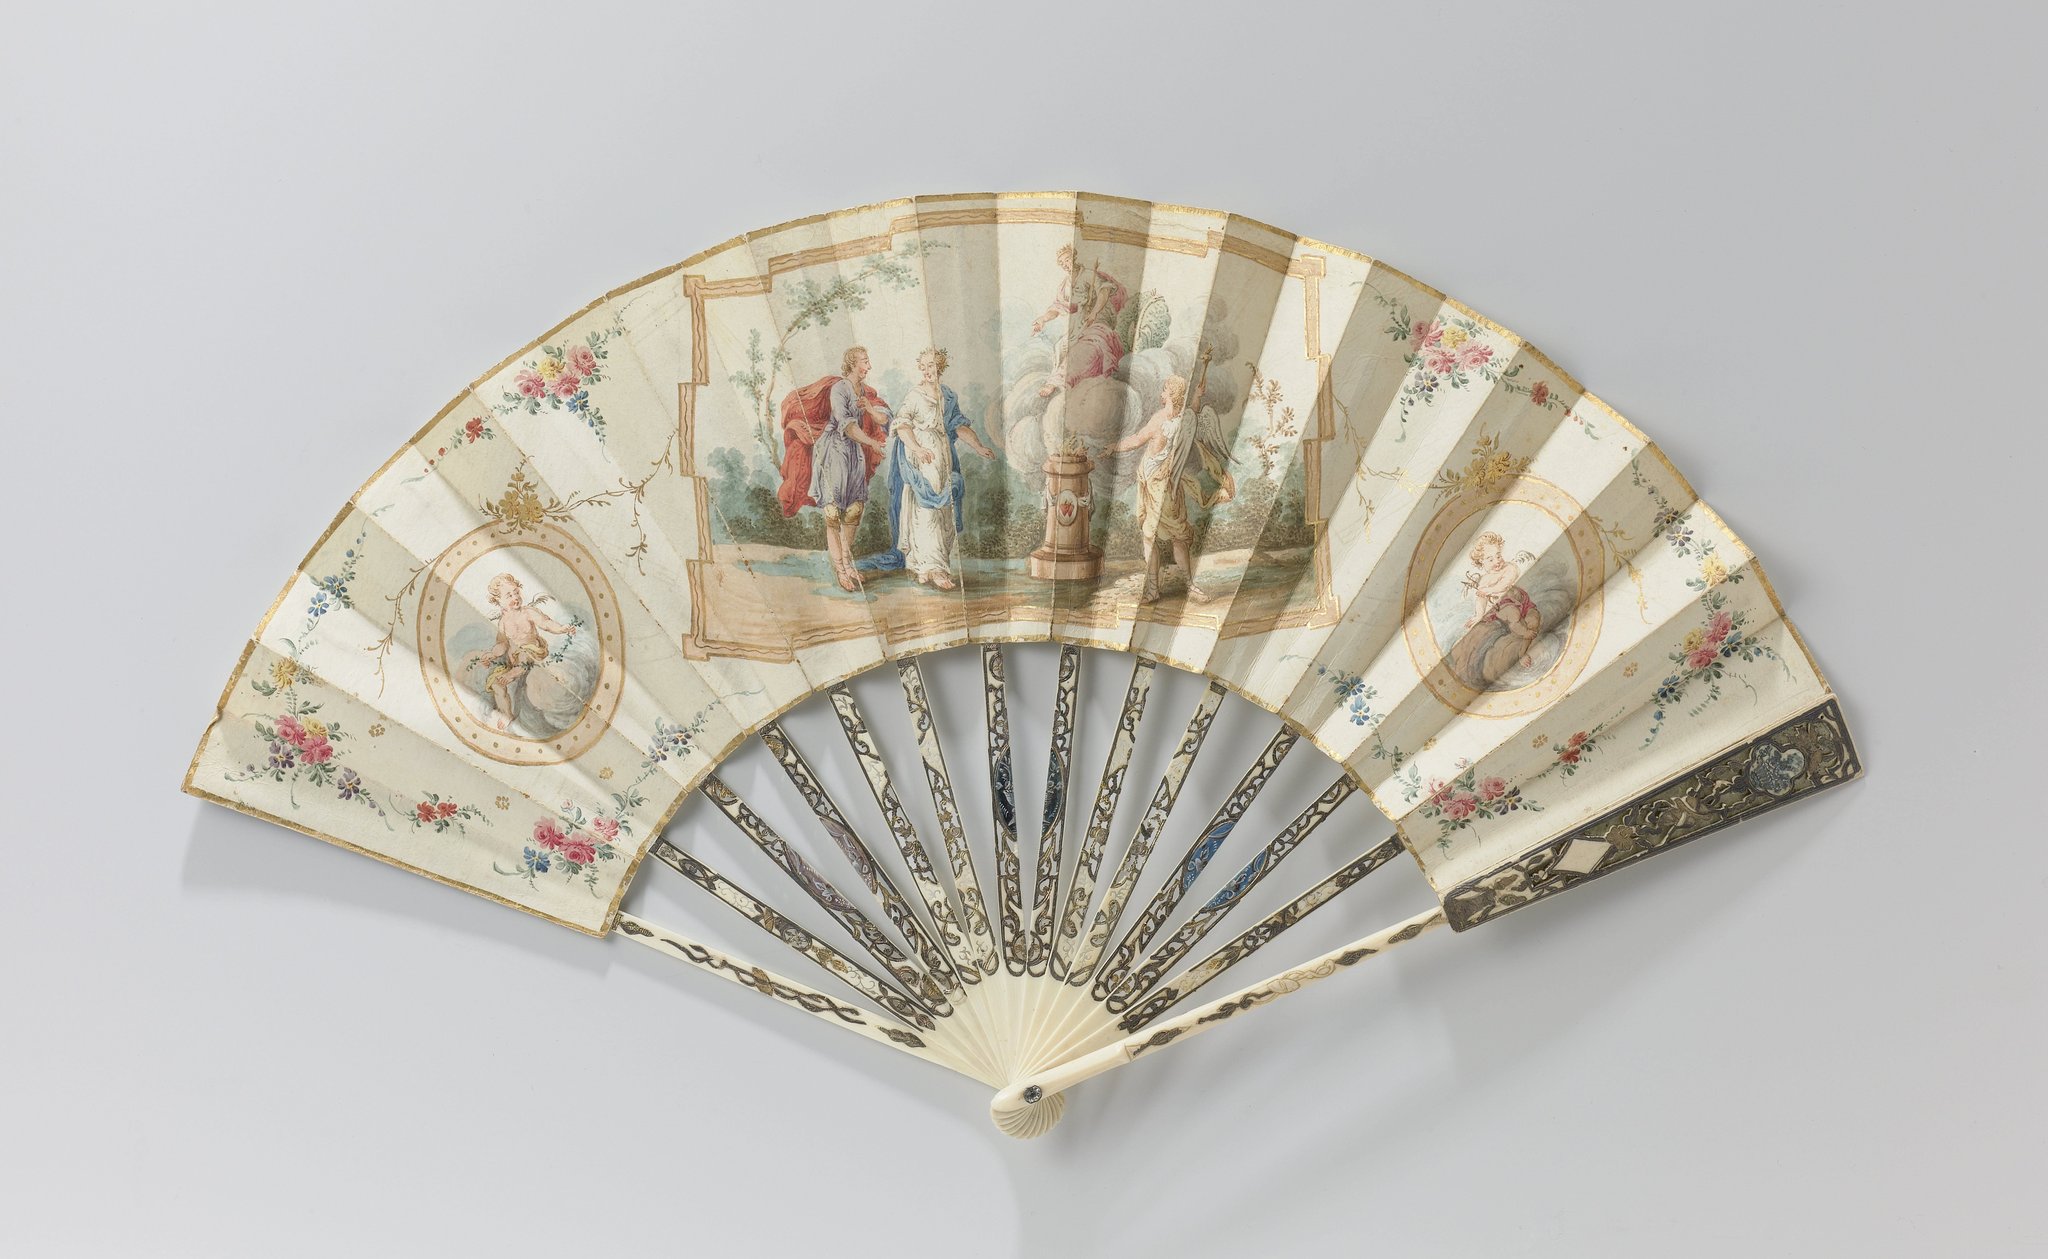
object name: vouwwaaier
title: Vouwwaaier met blad van papier waarop met aquarel een huwelijksvoorstelling is geschilderd, op een montuur van gesneden ivoor met métal en quatre couleurs en geschilderde medaillons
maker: Anonymous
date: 1775-1799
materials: gold leaf, ivory, paint, paper, paste, silver leaf, watercolor, wood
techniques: cutting, gilding, silvering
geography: netherlands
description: Vouwwaaier met blad van papier waarop een huwelijksvoorstelling, op een montuur van gesneden ivoor met métal en quatre couleurs en geschilderde medaillons. Het blad is verdeeld in drie vlakken met een rechthoekig centrale cartouche geflankeerd door twee ovale medaillons. Links van een huwelijksaltaar waaraan een schild met twee brandende harten en waarop een vuur brandt, staan een man en een vrouw in classicistische kledij. Hij met romeinse sandalen, een poffende kniebroek waarover een tuniek en een wapperende omslagdoek. Zij met een bladslinger in het korte kroesende haar, een lange witte tuniek, een omslagdoek en blote voeten in romeinse sandalen. Boven het altaar zweeft Juno met de pauw op een wolk en rechts van het altaar staat Amor. In de ovalen aan weerszijden een putto op een wolk met links een bloemsinger en rechts een pijl in de hand. Het geheel is omgeven door veelkleurige bloemslingers. Op de achterkant van het blad in het midden een toef rozen. Het ivoren montuur bestaat uit 14 niet aaneengesloten benen met drie met tempera beschilderde medaillons, waarop brandende harten en een schaal met bloemen. Op de buitenbenen zijn onder elkaar een vierpas met geschilderde bloemenmand, een trofee met platte strohoed en doedelzak, een onversierde ivoren ruit en een brandend huwelijksaltaar geplaatst. Sluitpin met strassteentje. Huwelijkswaaier.